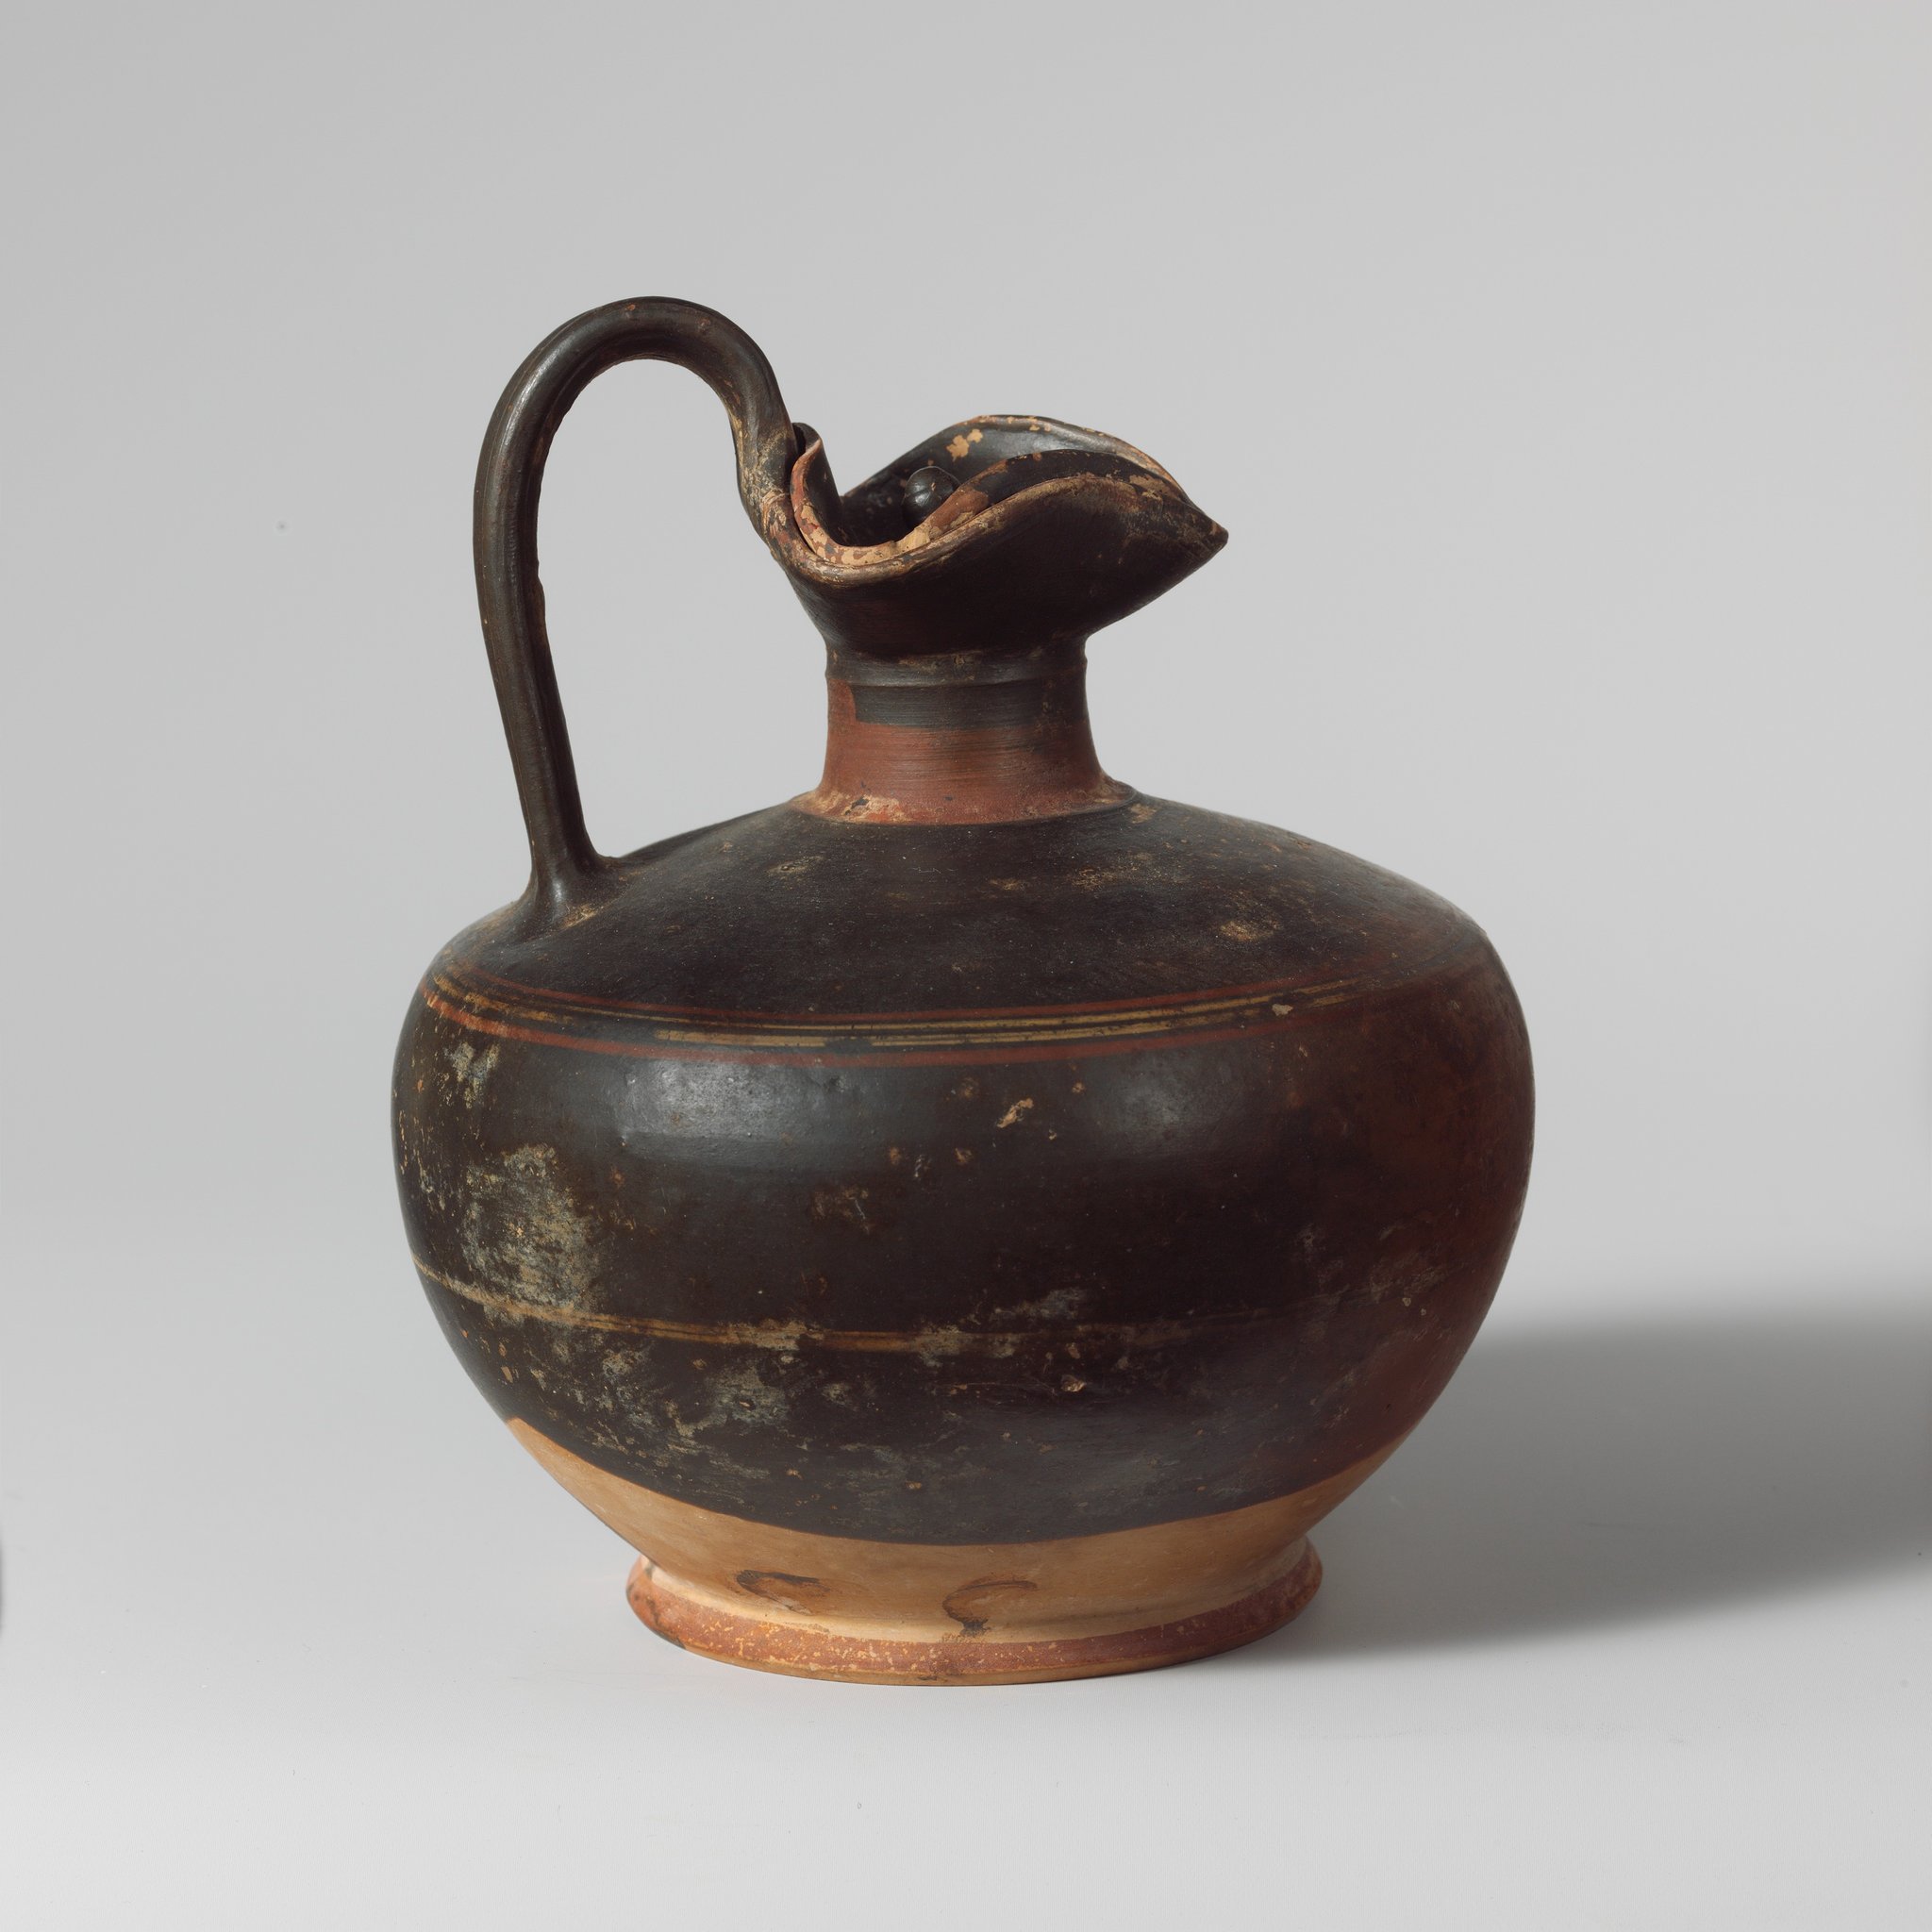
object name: oinochoe with lid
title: Terracotta oinochoe (jug) with lid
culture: greek, corinthian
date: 600-501 BCE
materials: terracotta